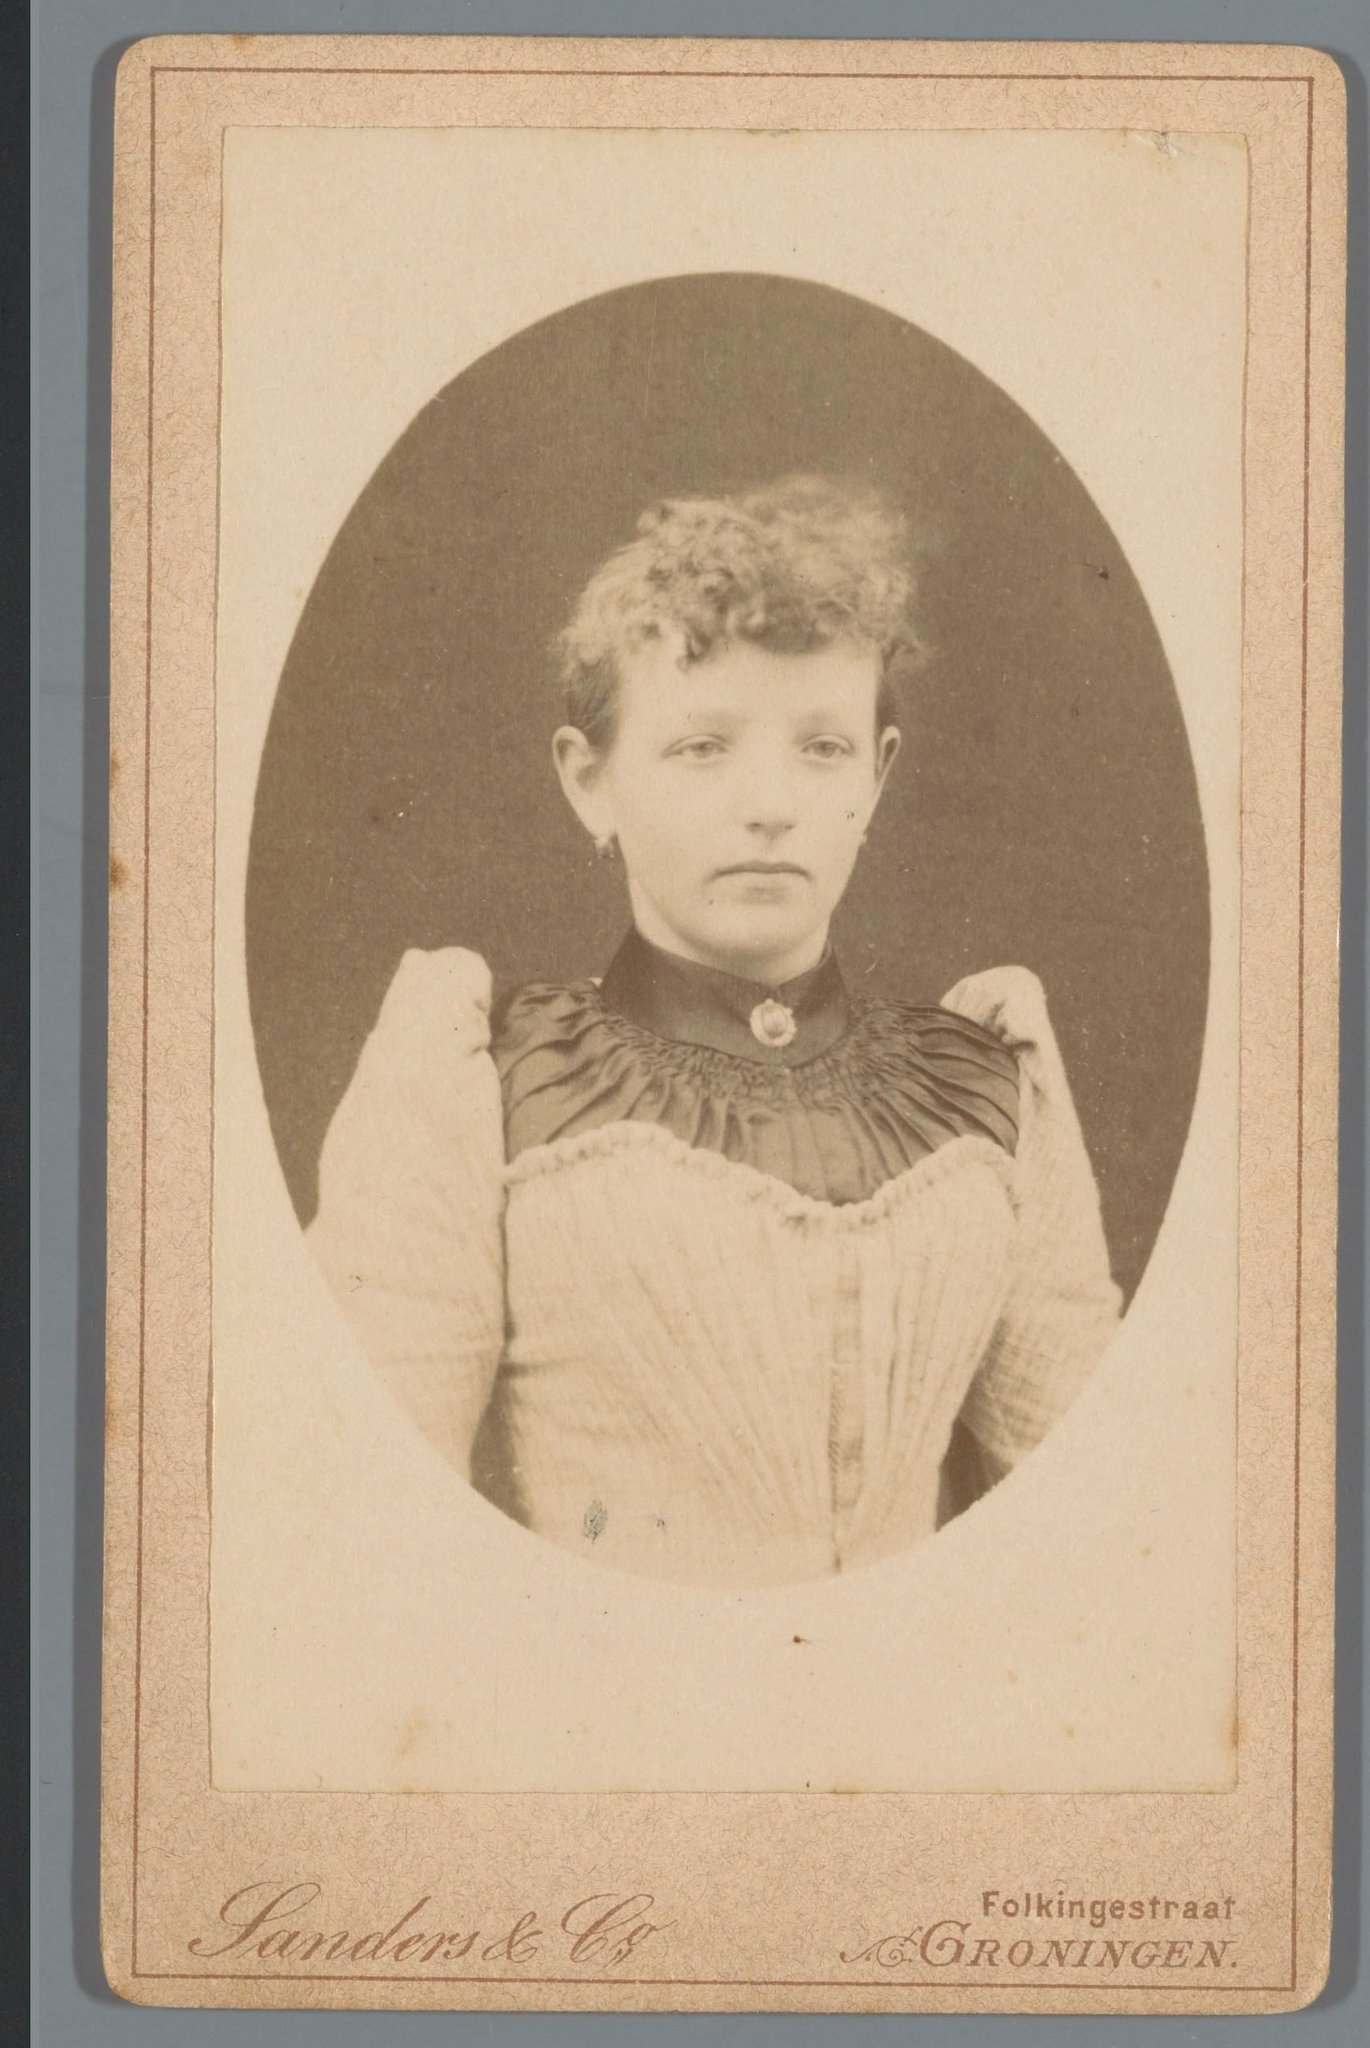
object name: photograph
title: Portret van een onbekende vrouw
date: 1857-1901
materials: cardboard, paper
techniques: albumen print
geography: groningen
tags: historical persons - bb - woman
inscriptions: inscription: ‘Sanders & Co/ PHOTOGRAPHEN/ Folkingestraat nabij de BEURS/ GRONINGEN./ Deze Plaat blijft ter nabestelling bewaard./ Inrichting voor Vergrootingen./ Trapp&Münch, Berlin.’